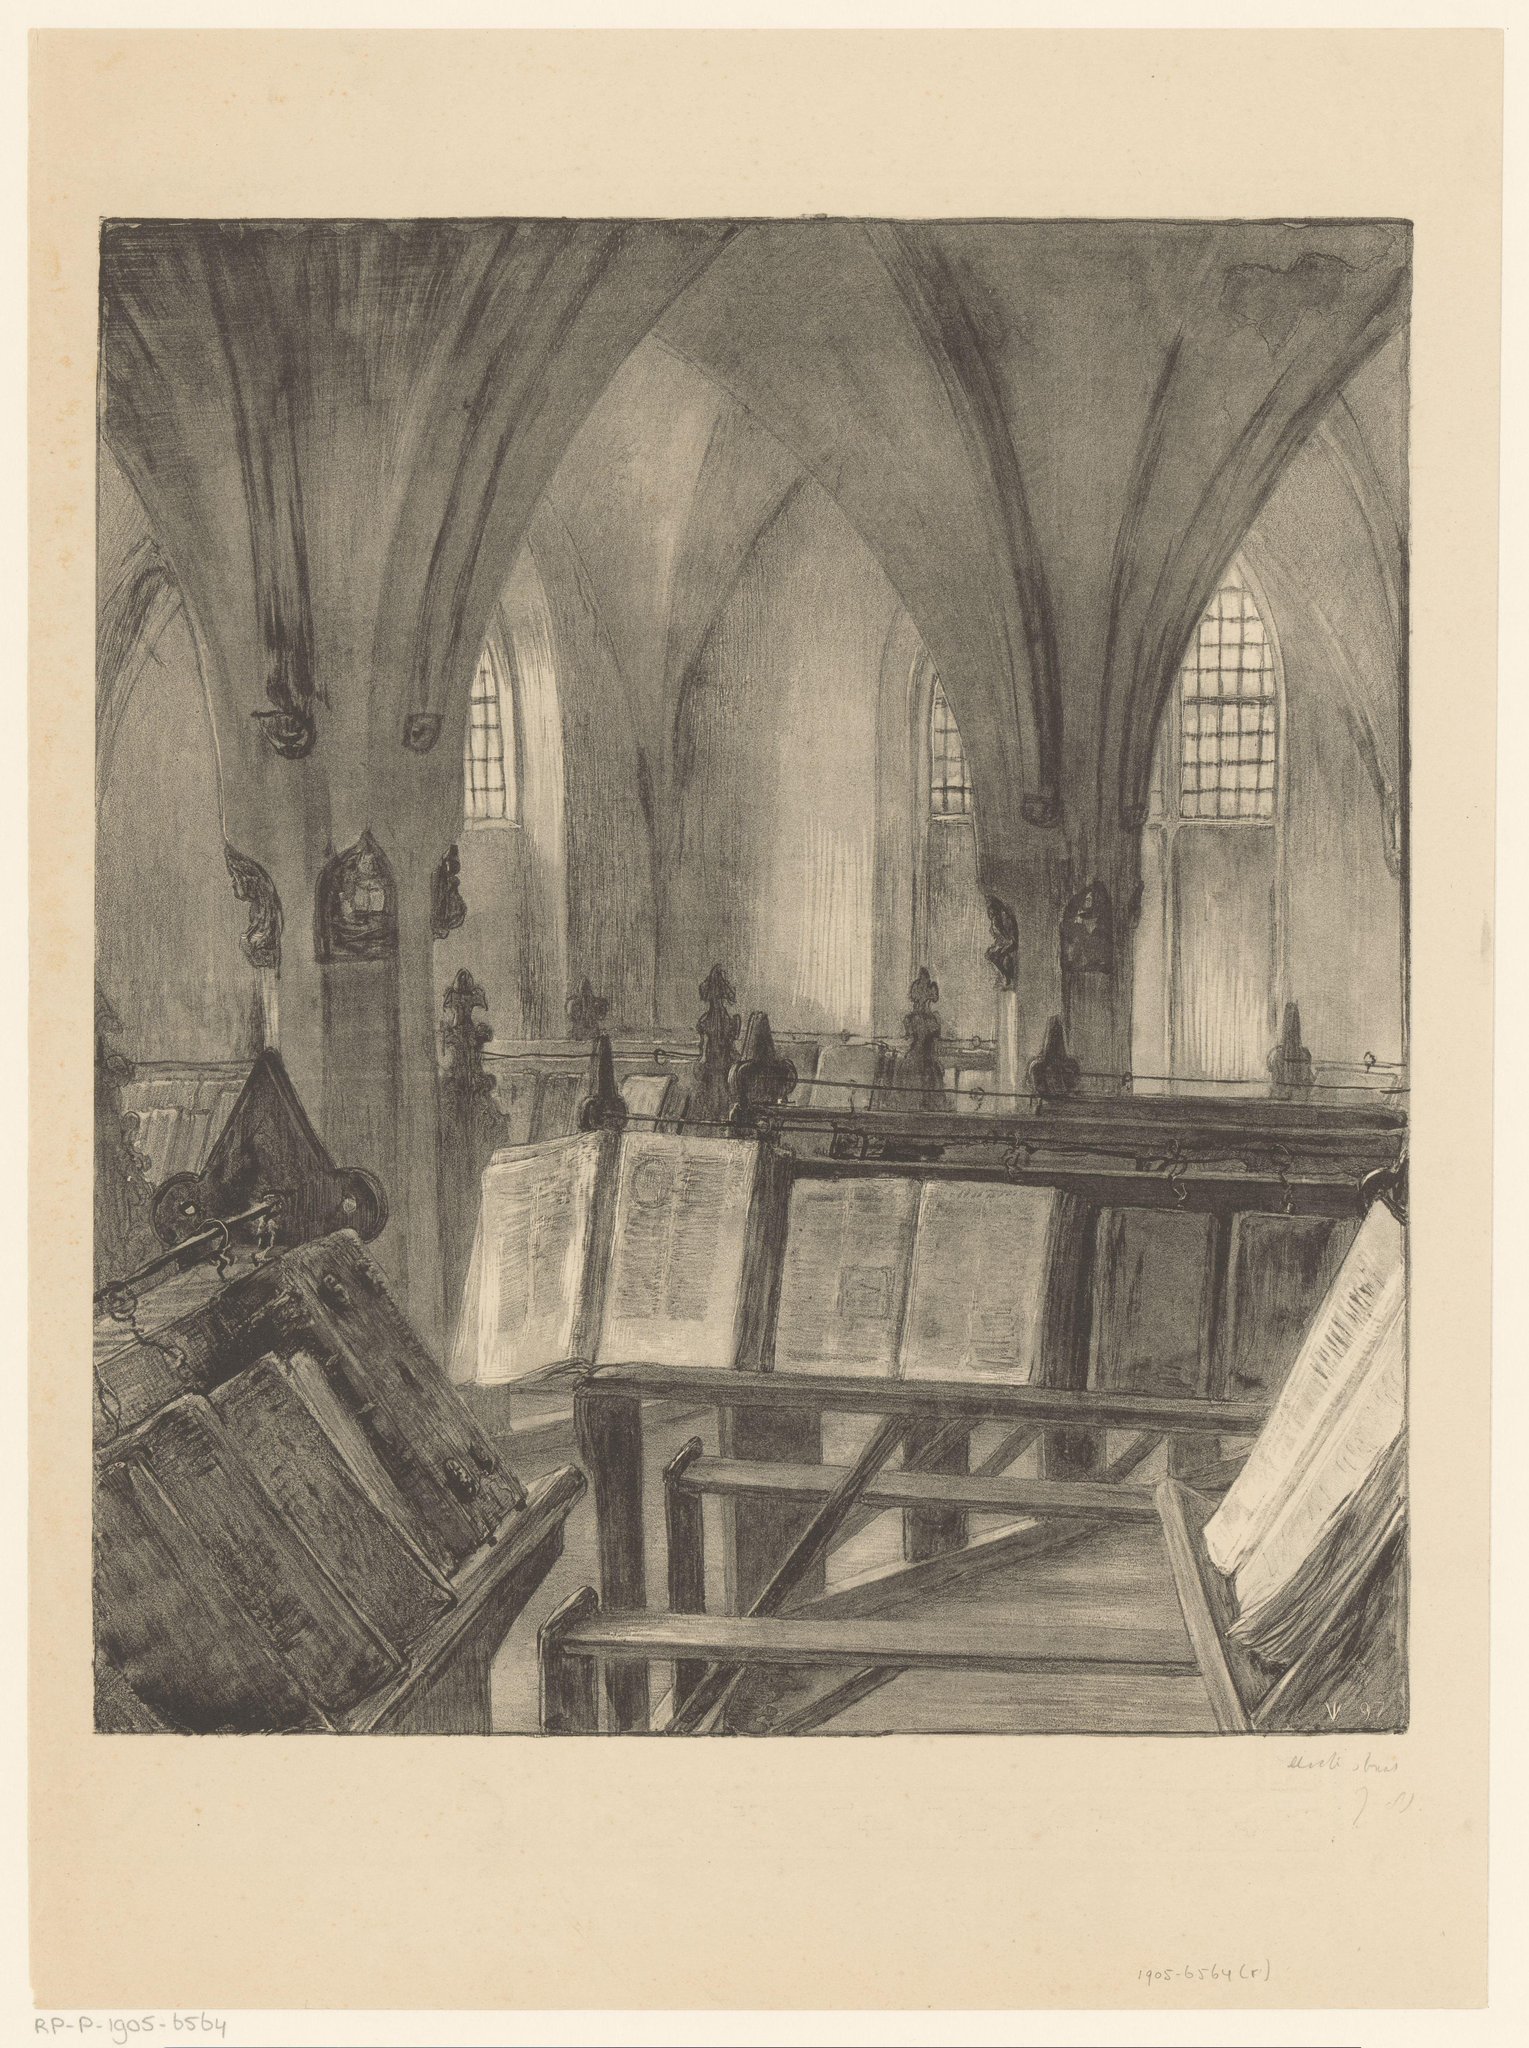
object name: print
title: Librije te Zutphen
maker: jan veth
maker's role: designer, draughtsman, painter, print maker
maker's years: 1864-1925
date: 1897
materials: paper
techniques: lithograph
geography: netherlands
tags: public library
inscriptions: inscription: ‘eerste staat / J.V.’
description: Deze prent werd uitgegeven als bijvoegsel bij De Kroniek op 26 september 1897.